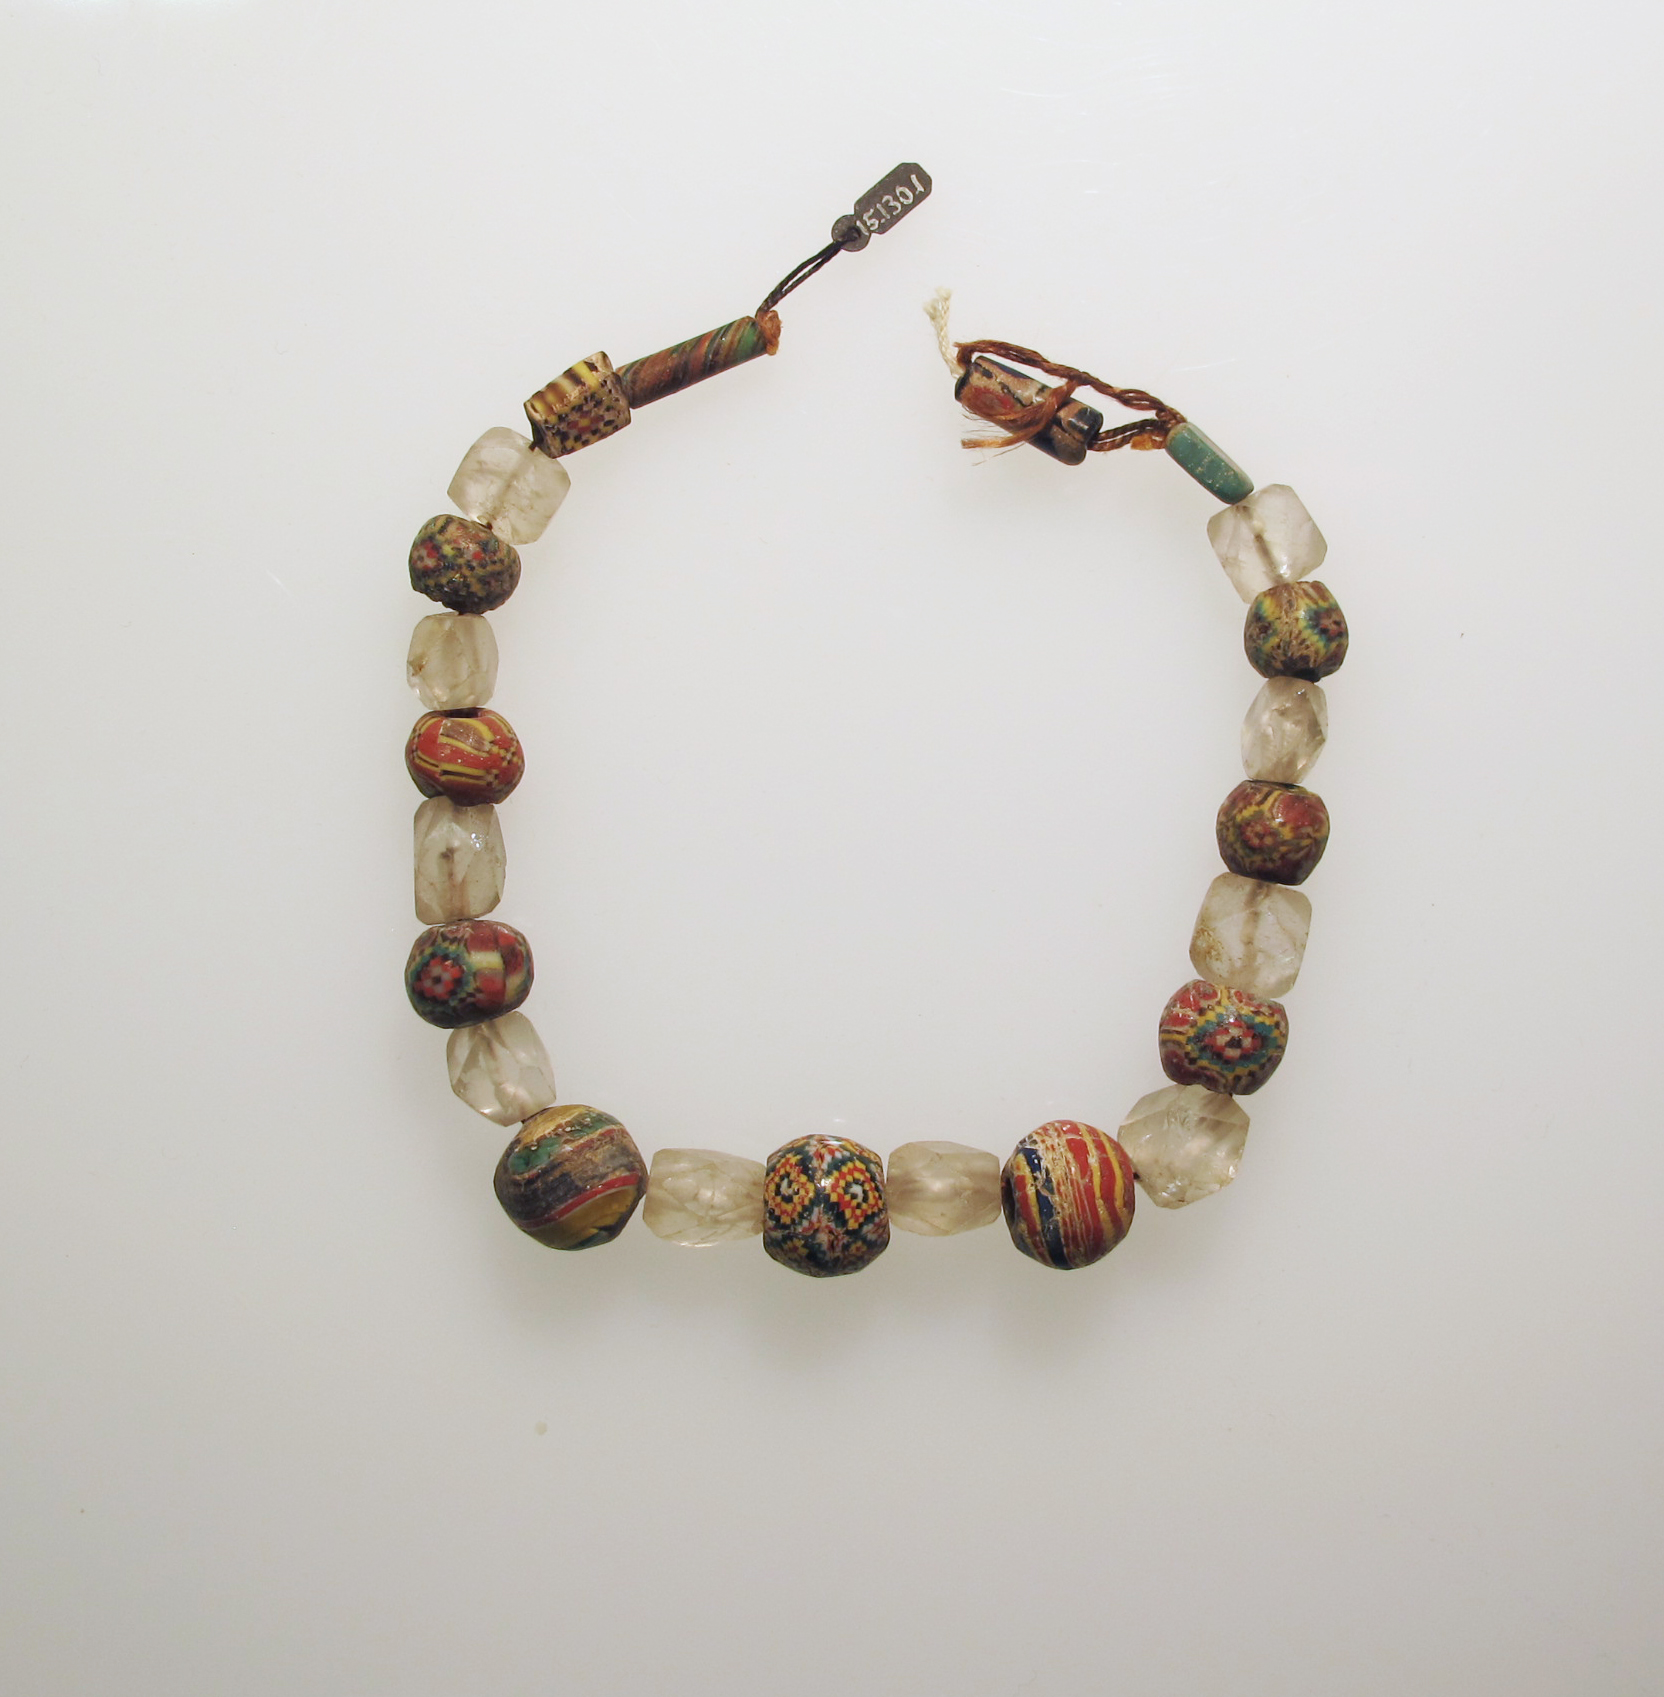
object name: necklace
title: Glass and rock crystal beads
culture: roman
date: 100 BCE-100 CE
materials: glass, quartz